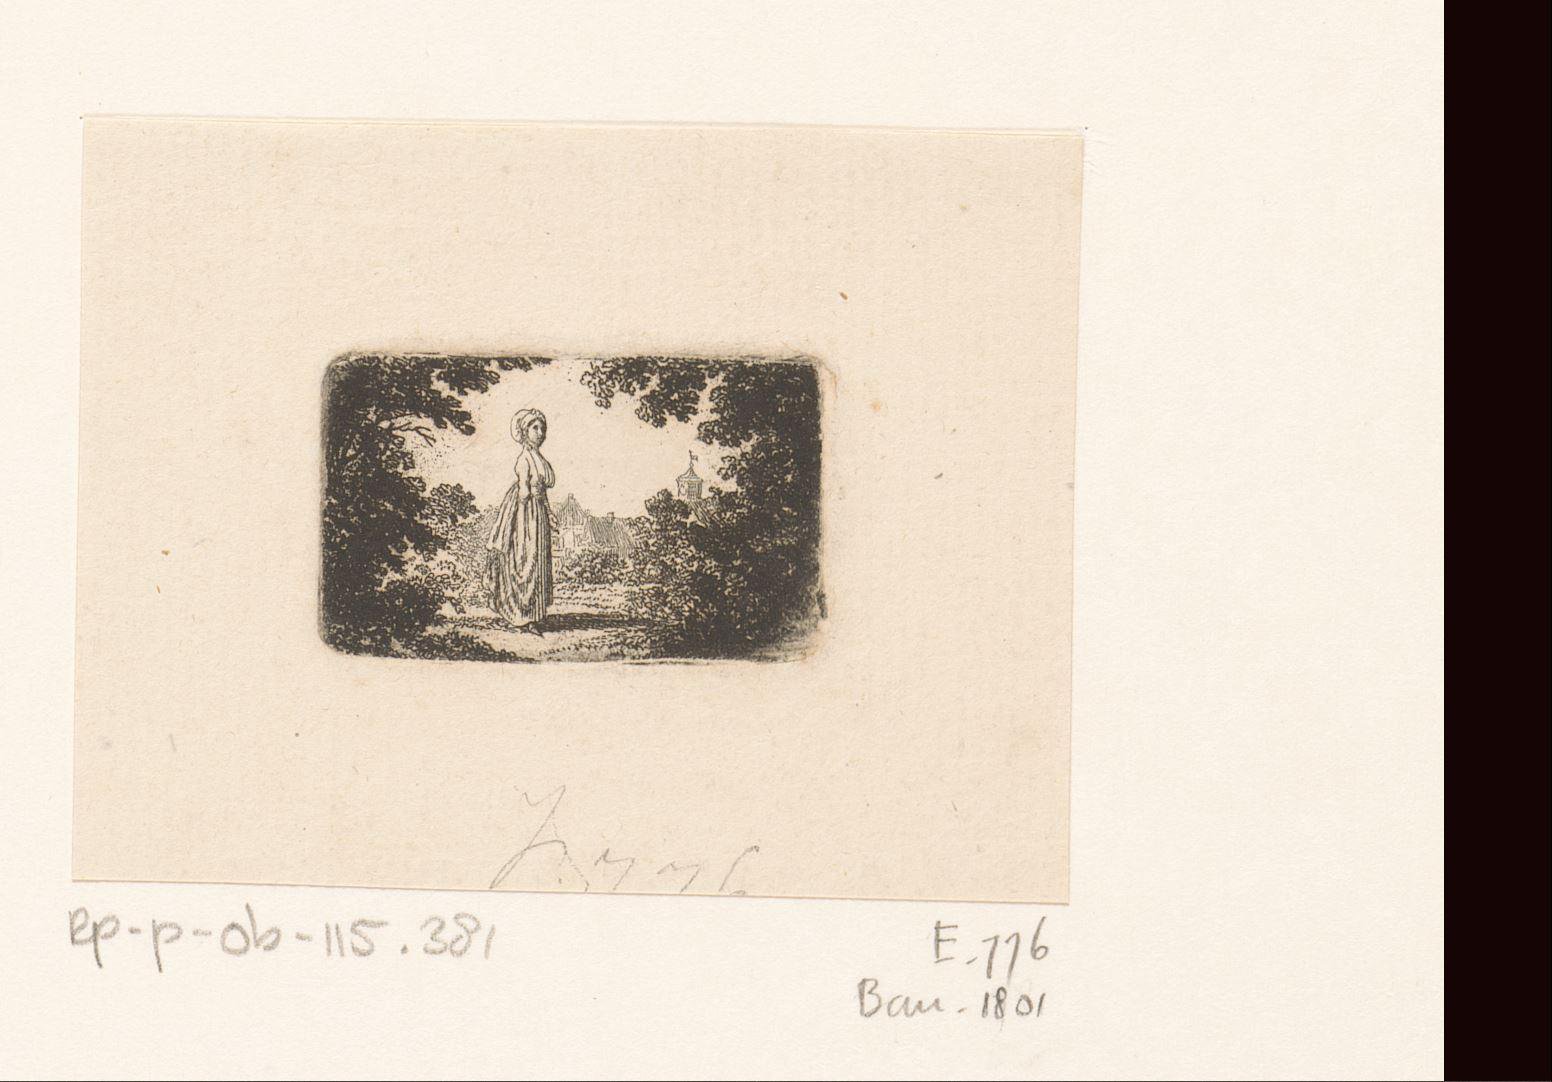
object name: print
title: Wandelende dame gezien vanuit het groen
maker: daniel nikolaus chodowiecki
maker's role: draughtsman, print maker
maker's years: 1726-1801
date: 1795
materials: paper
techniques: etching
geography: berlin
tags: adolescent, young woman, maiden, shrubs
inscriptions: collector's mark: Lugt 2228